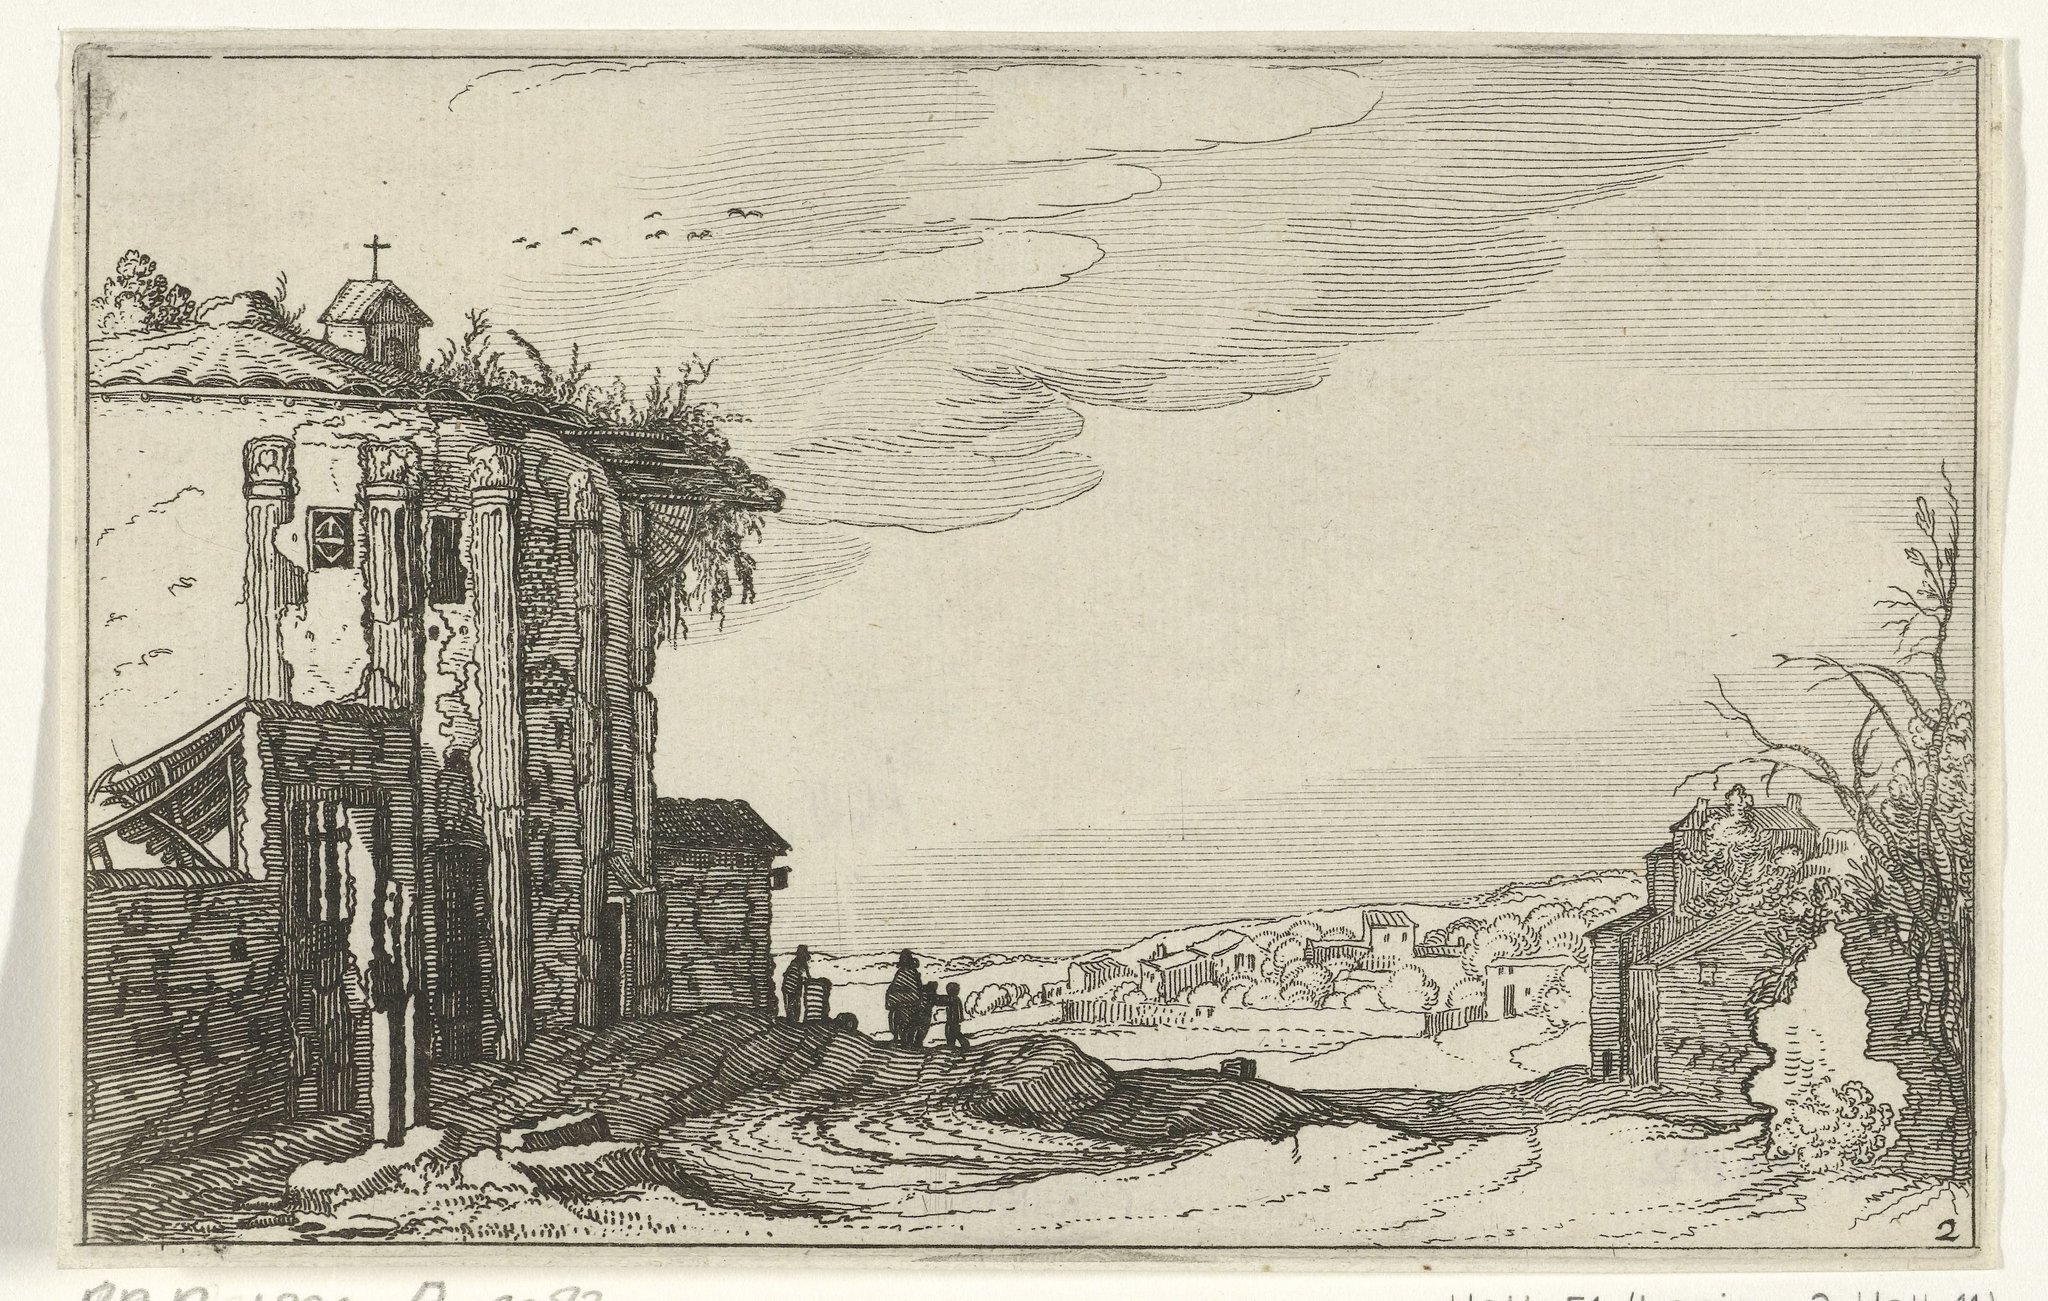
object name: print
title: Ruïne met korintische zuilen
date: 1618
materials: paper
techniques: etching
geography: amsterdam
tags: corinthian order ~ architecture (+ architecture), ruin of a building ~ architecture, landscape with ruins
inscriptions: collector's mark: Lugt 2228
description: Aan een weg ligt links een ruïne van een klassiek gebouw, waarvan nog vier korintische zuilen overeind staan. Daarnaast een rond gebouw, waarboven een kerktoren of kapel uitsteekt. Op de achtergrond een heuvelachtig landschap met gebouwen. Prent maakt deel uit van een serie Romeinse ruïnes en kustlandschappen naar een prentserie van Willem van Nieulandt.